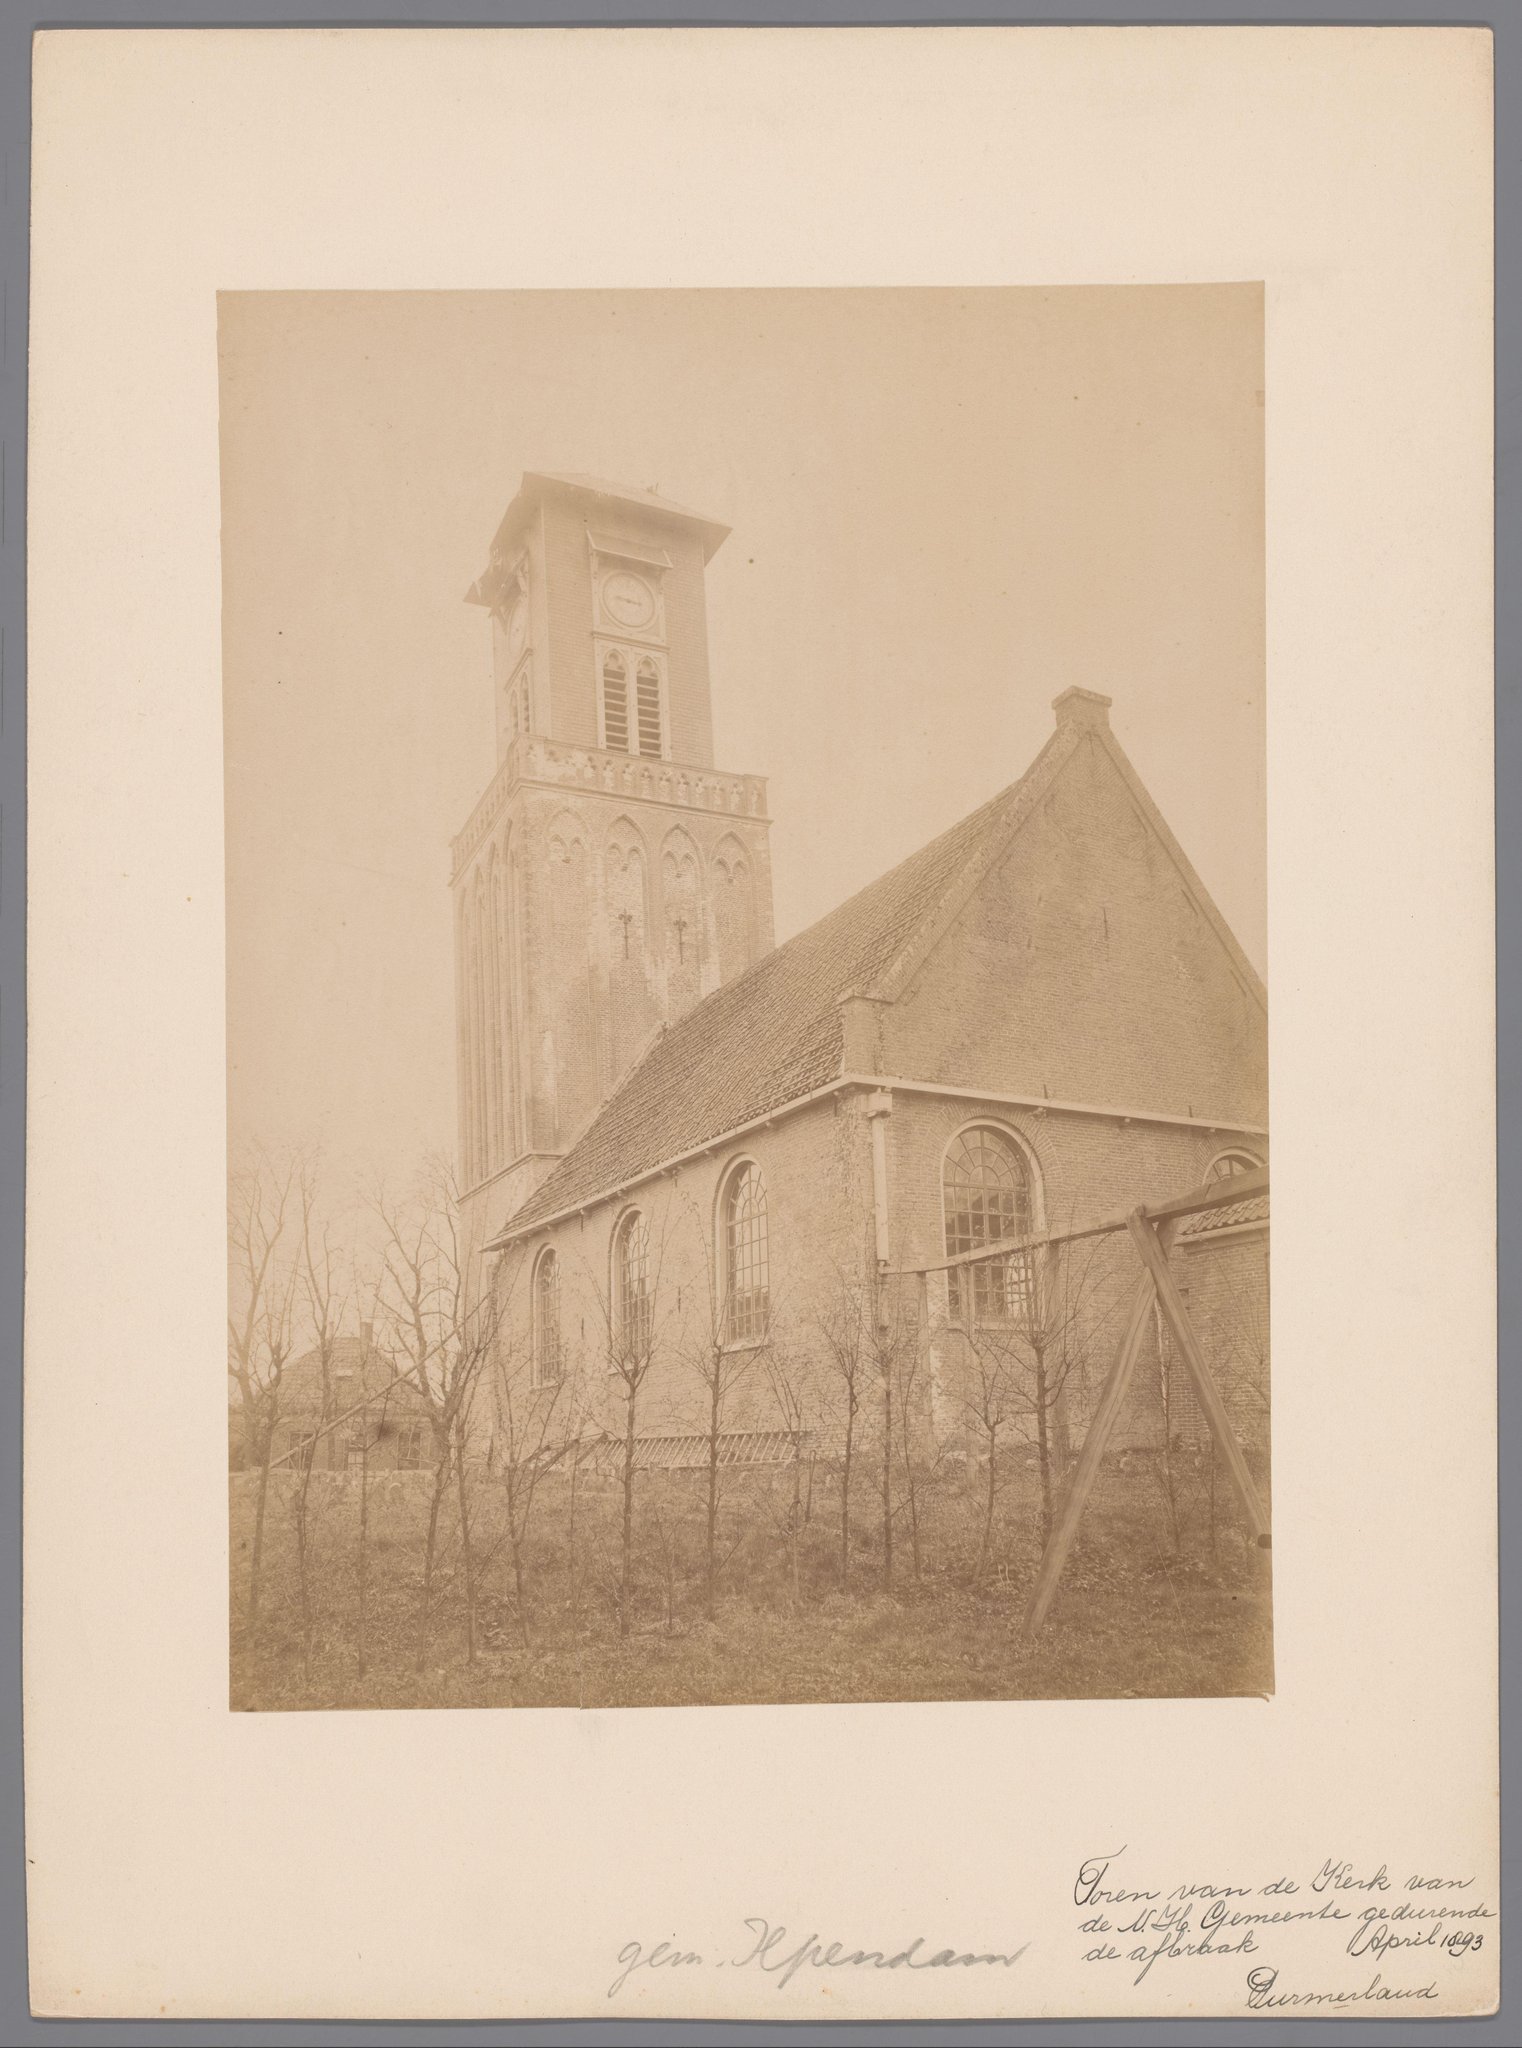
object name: photograph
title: Gezicht op de Hervormde Kerk te Purmerend tijdens de afbraak in 1893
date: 1893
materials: cardboard, photographic support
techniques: albumen print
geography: purmerend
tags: church (exterior)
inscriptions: annotation: ‘Toren v/d N.H. Kerk te Purmerlland gedurende de afbraak’, annotation: ‘Toren van de Kerk van de N.H. gemeente gedurende de afbraak/ April 1893/ Purmerland/ gem. Ilpendam’